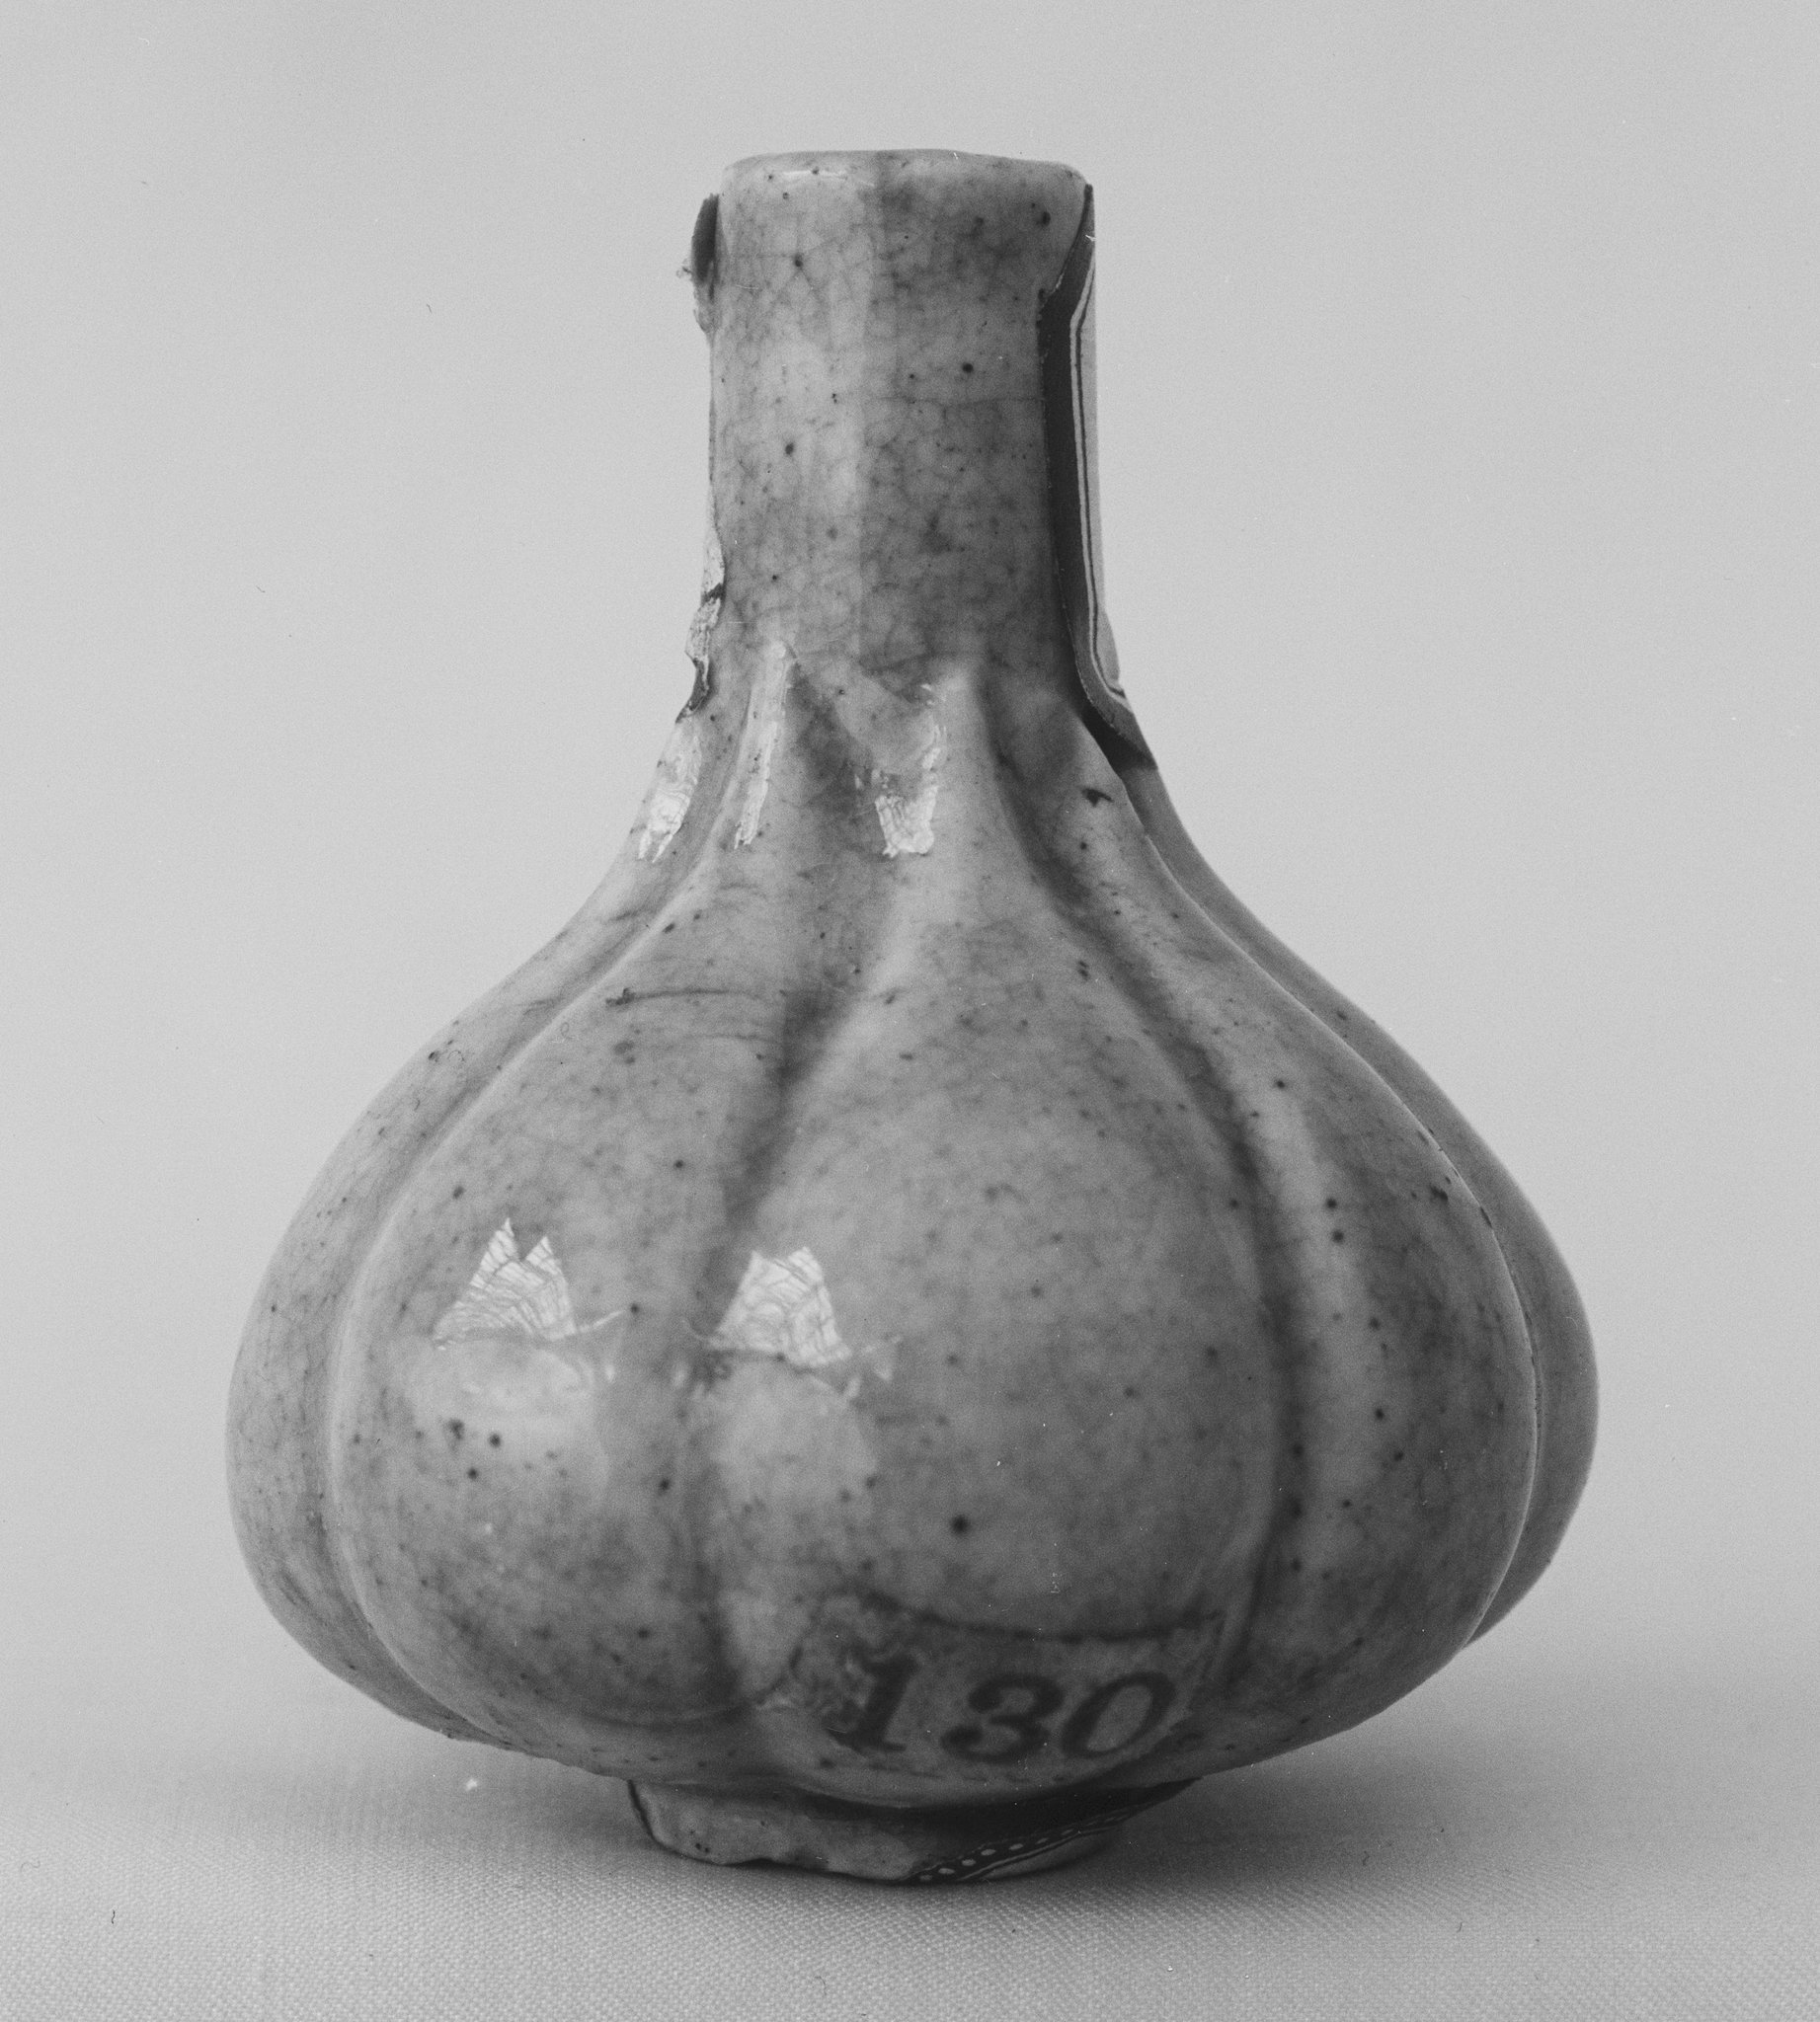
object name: vase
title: Miniature Vase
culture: chinese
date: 1801-1900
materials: glaze, porcelain